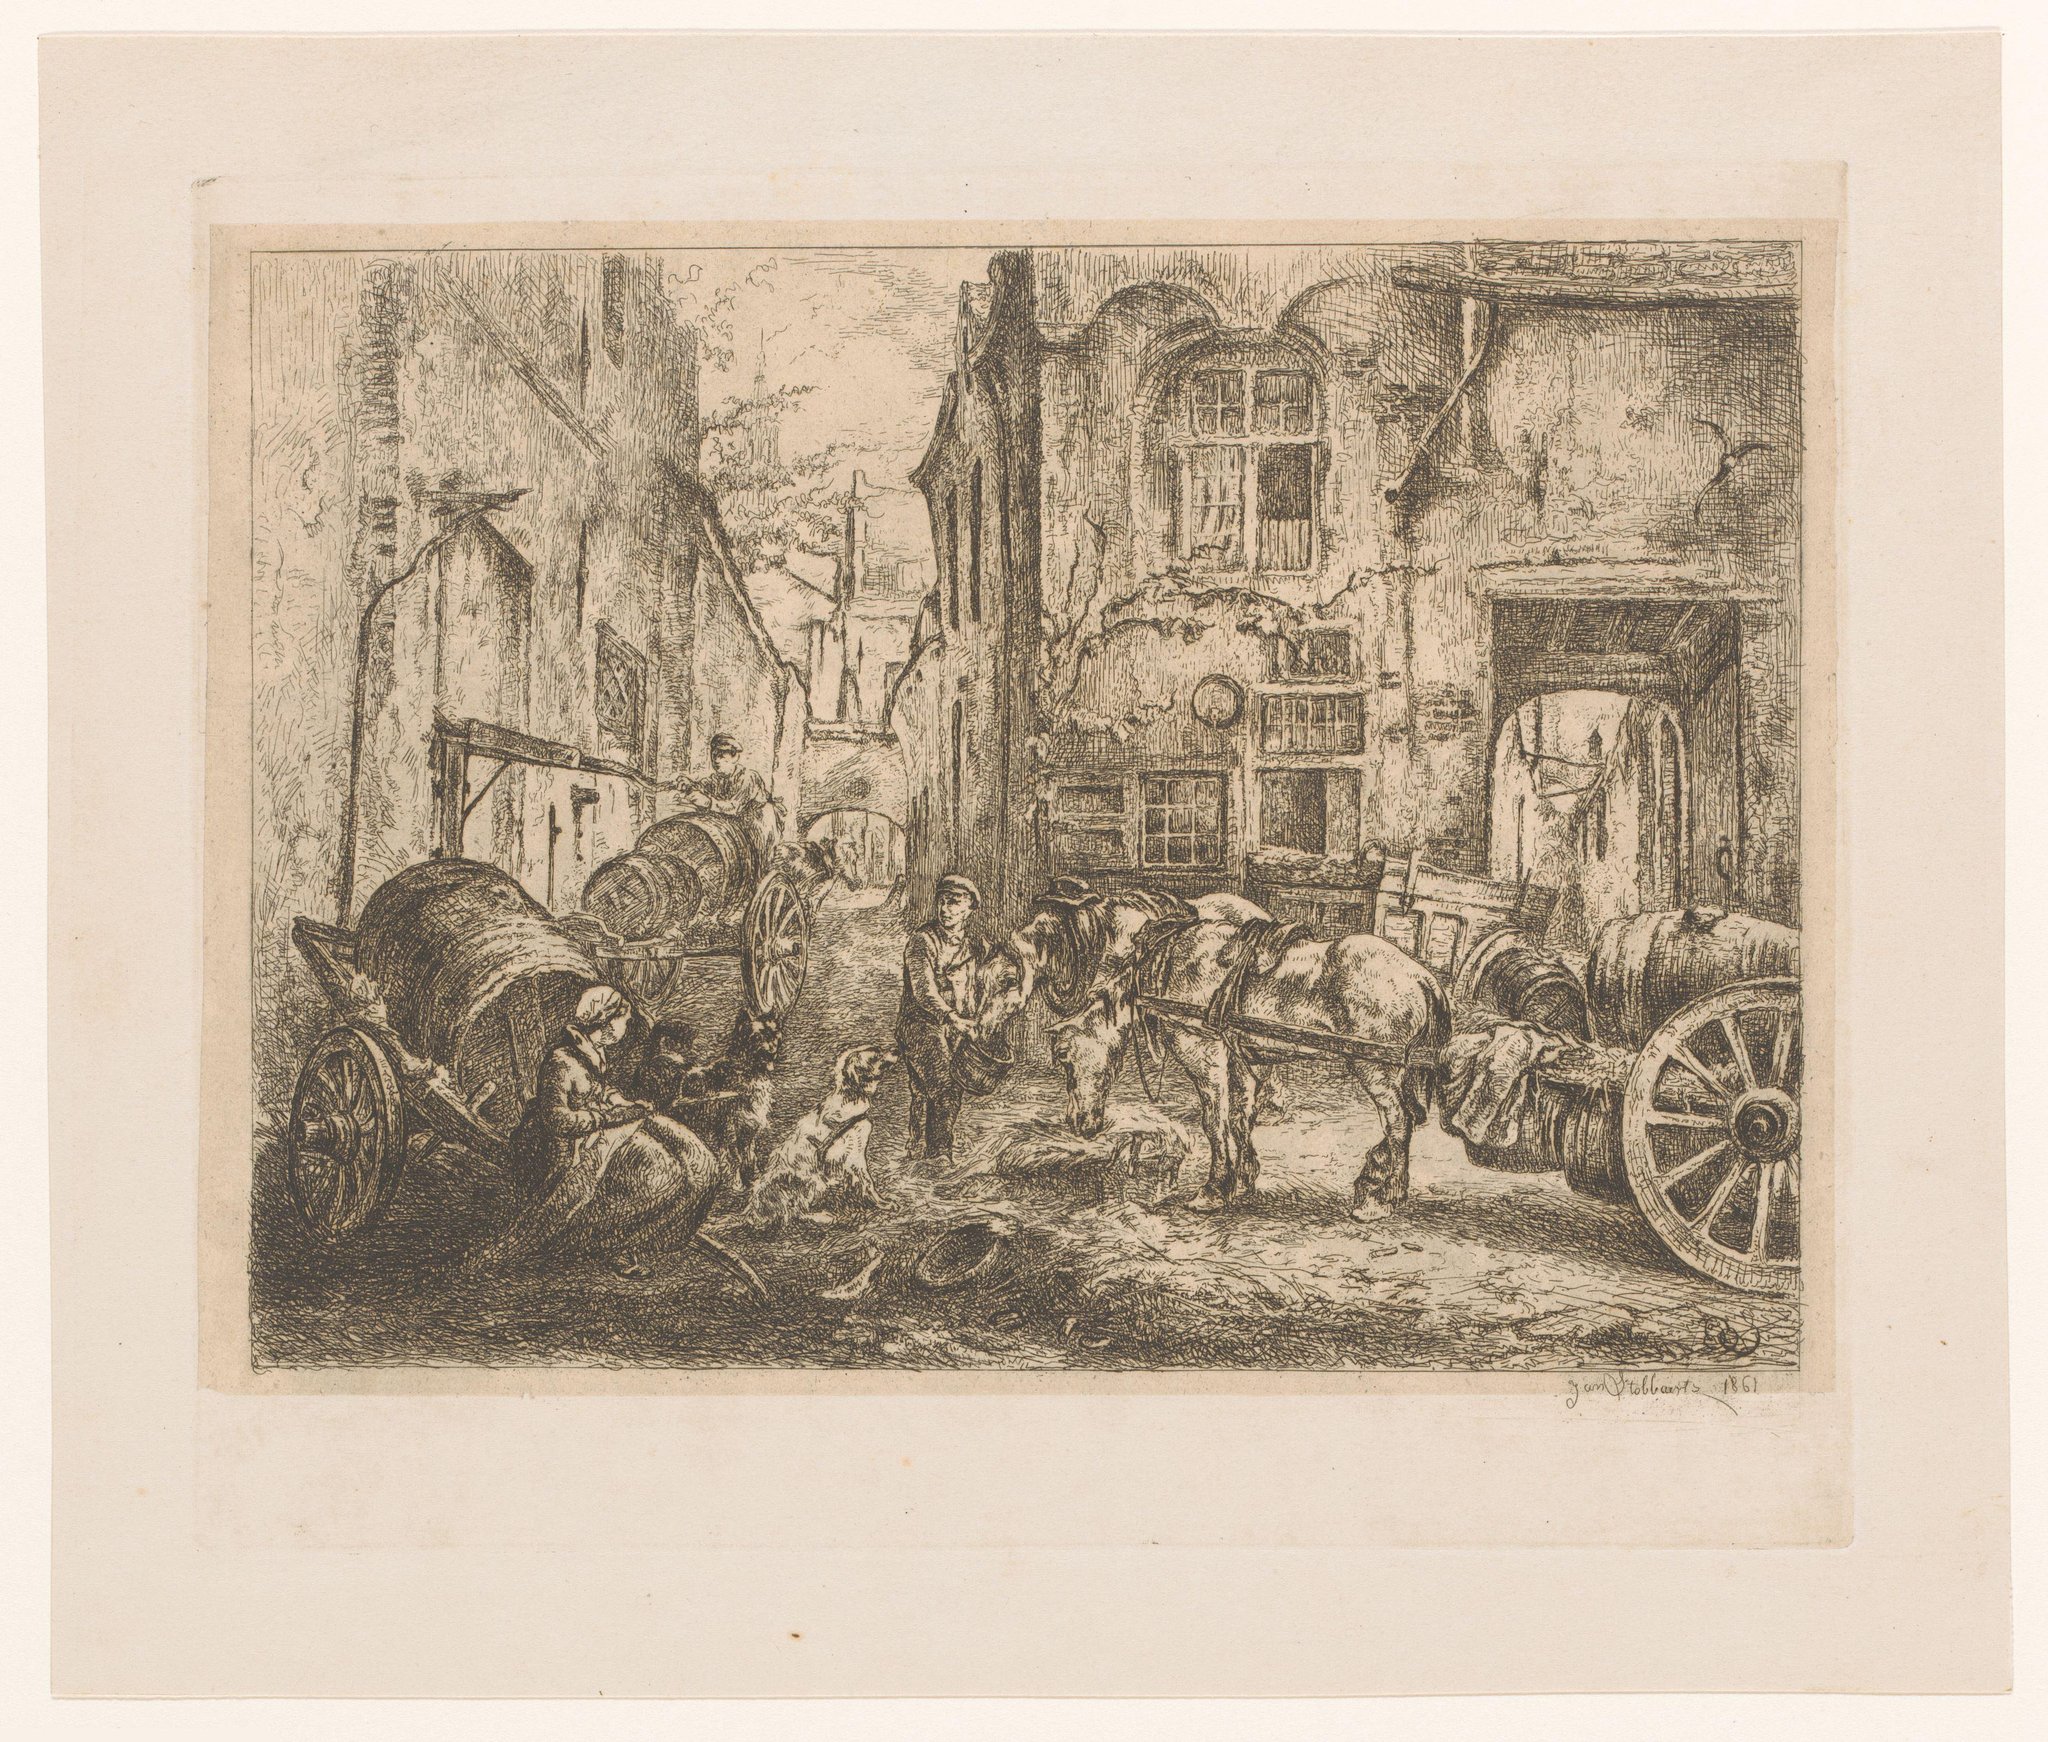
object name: print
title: Stadsgezicht met figuren en wagens op een kruispunt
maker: jan stobbaerts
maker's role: draughtsman, print maker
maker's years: 1838-1914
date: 1861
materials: paper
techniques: etching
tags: city-view in general; 'veduta', two-wheeled, animal-drawn vehicle, cross-roads, bifurcation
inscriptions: collector's mark: Lugt 2228, collector's mark: Lugt 1485